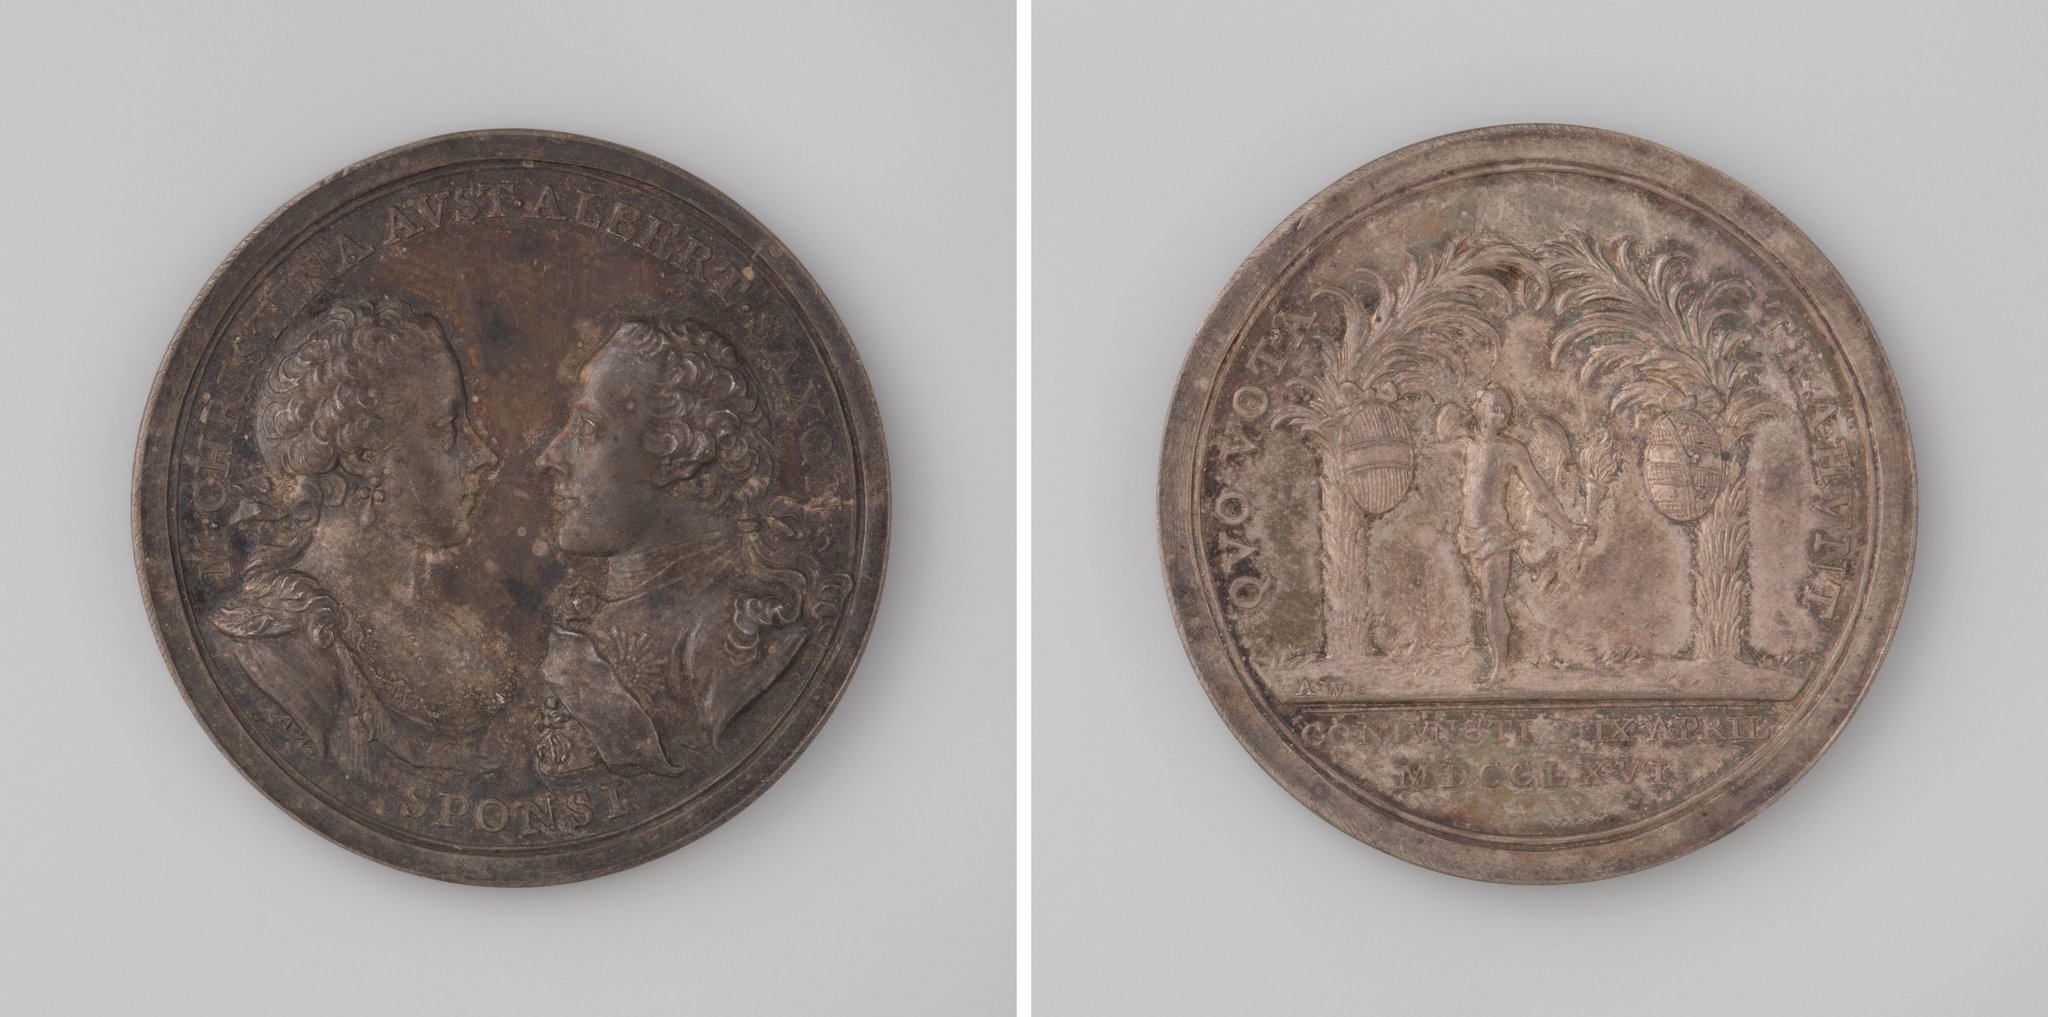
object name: history medal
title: Huwelijk van Maria Christina, aartshertogin van Oostenrijk en Albert, hertog van Saksen-Teschen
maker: anton franz widemann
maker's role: medailleur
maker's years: 1724-1792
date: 1766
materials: silver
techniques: striking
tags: albert casimir van saksen-teschen, maria christina van oostenrijk (1742-1798)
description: Zilveren penning. Voorzijde: naar elkaar gekeerde borststukken van man en vrouw binnen omschrift. Keerzijde: Amor met brandende fakkel staande tussen twee palmbomen, hangt in elke boom een wapenschild binnen omschrift; afsnede: opschrift